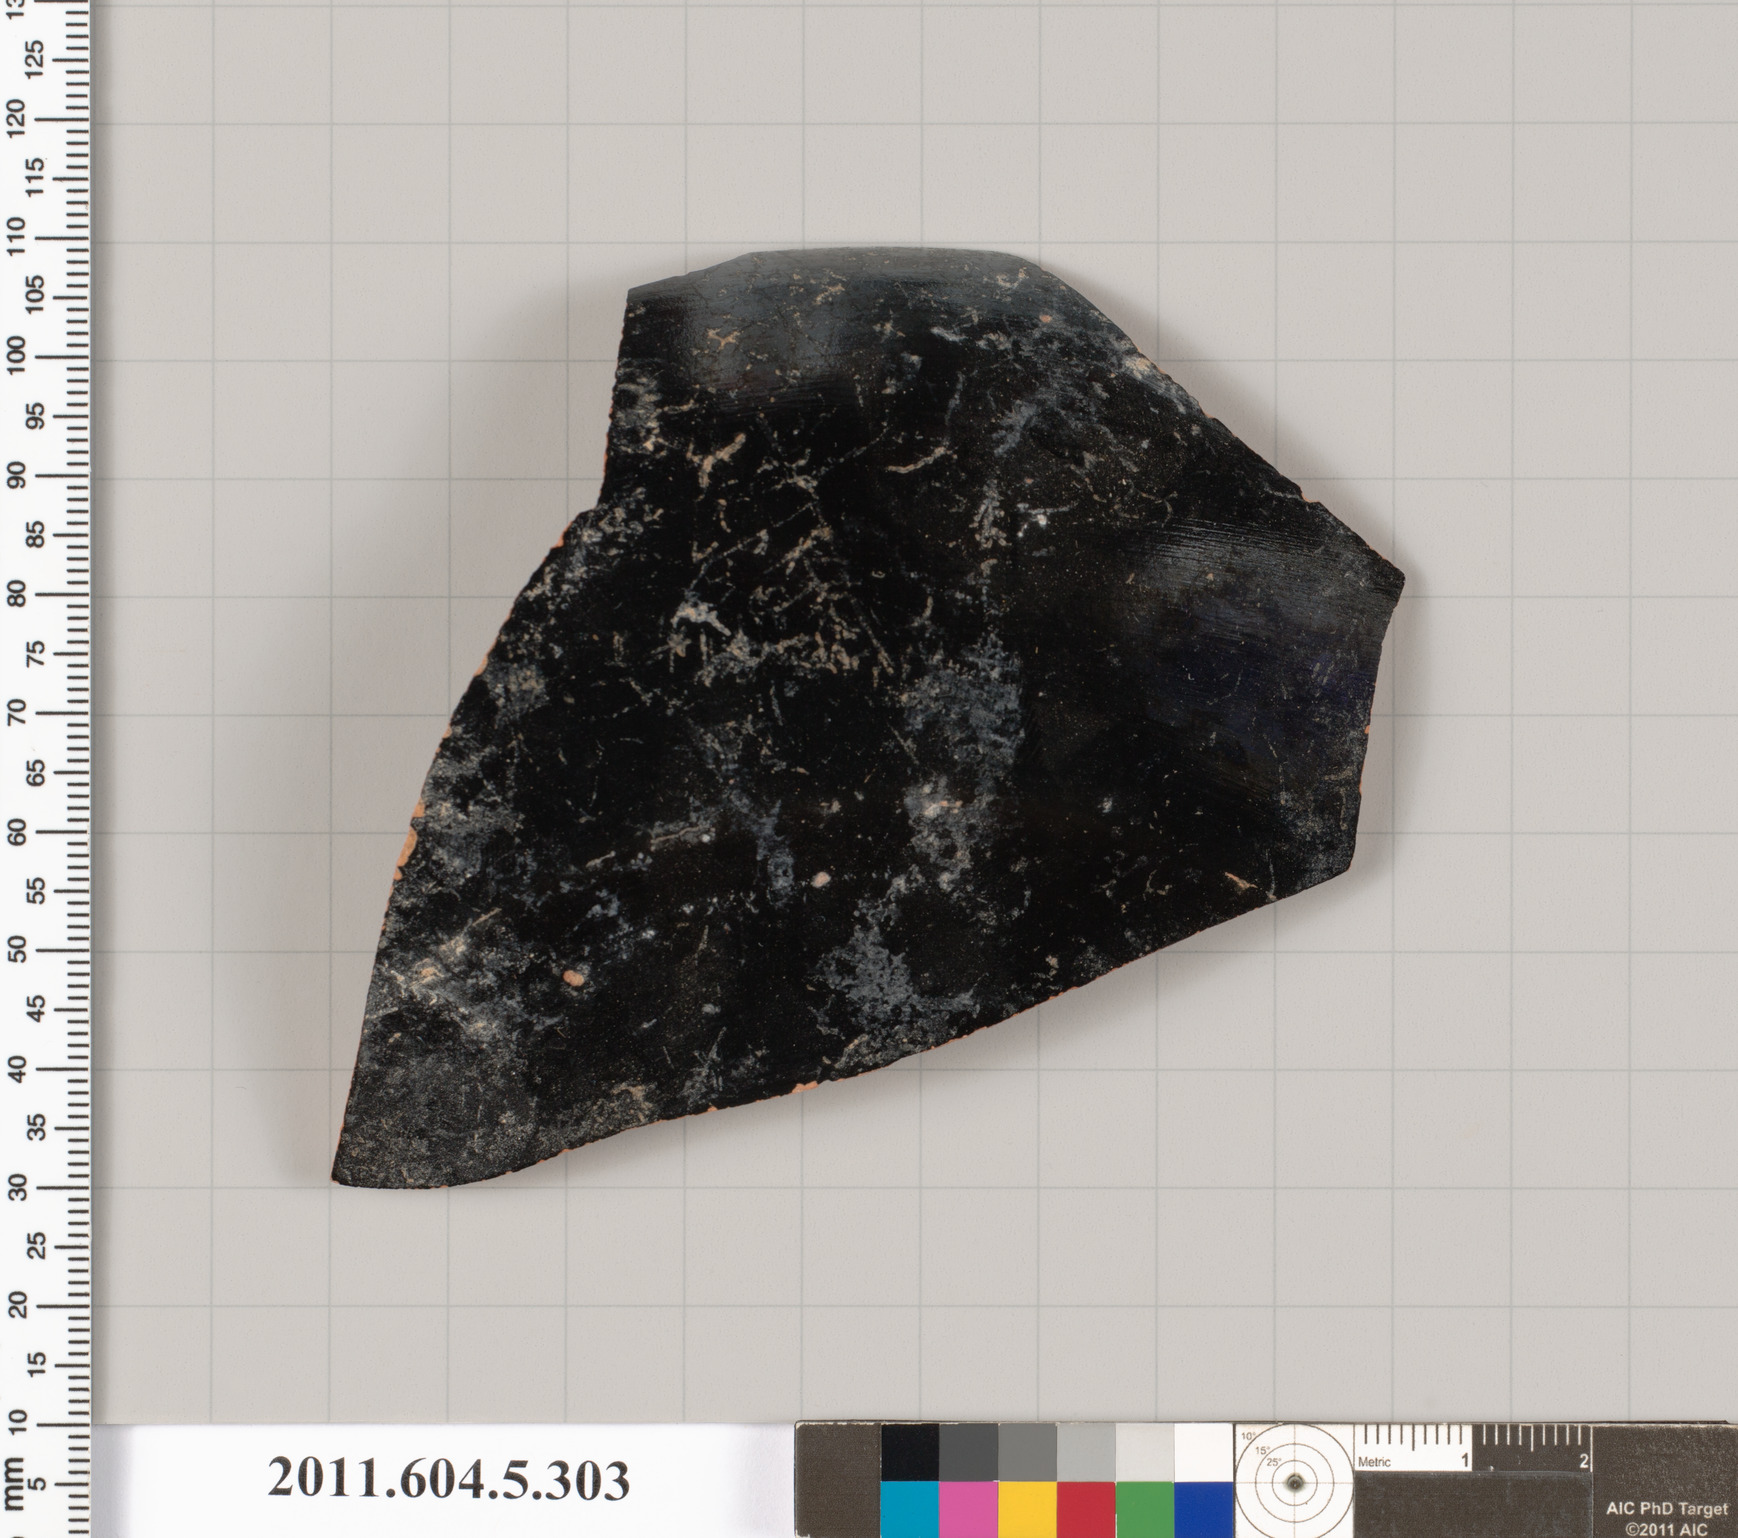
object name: kylix fragment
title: Terracotta rim fragment of a kylix (drinking cup)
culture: greek, attic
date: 600-401 BCE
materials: terracotta